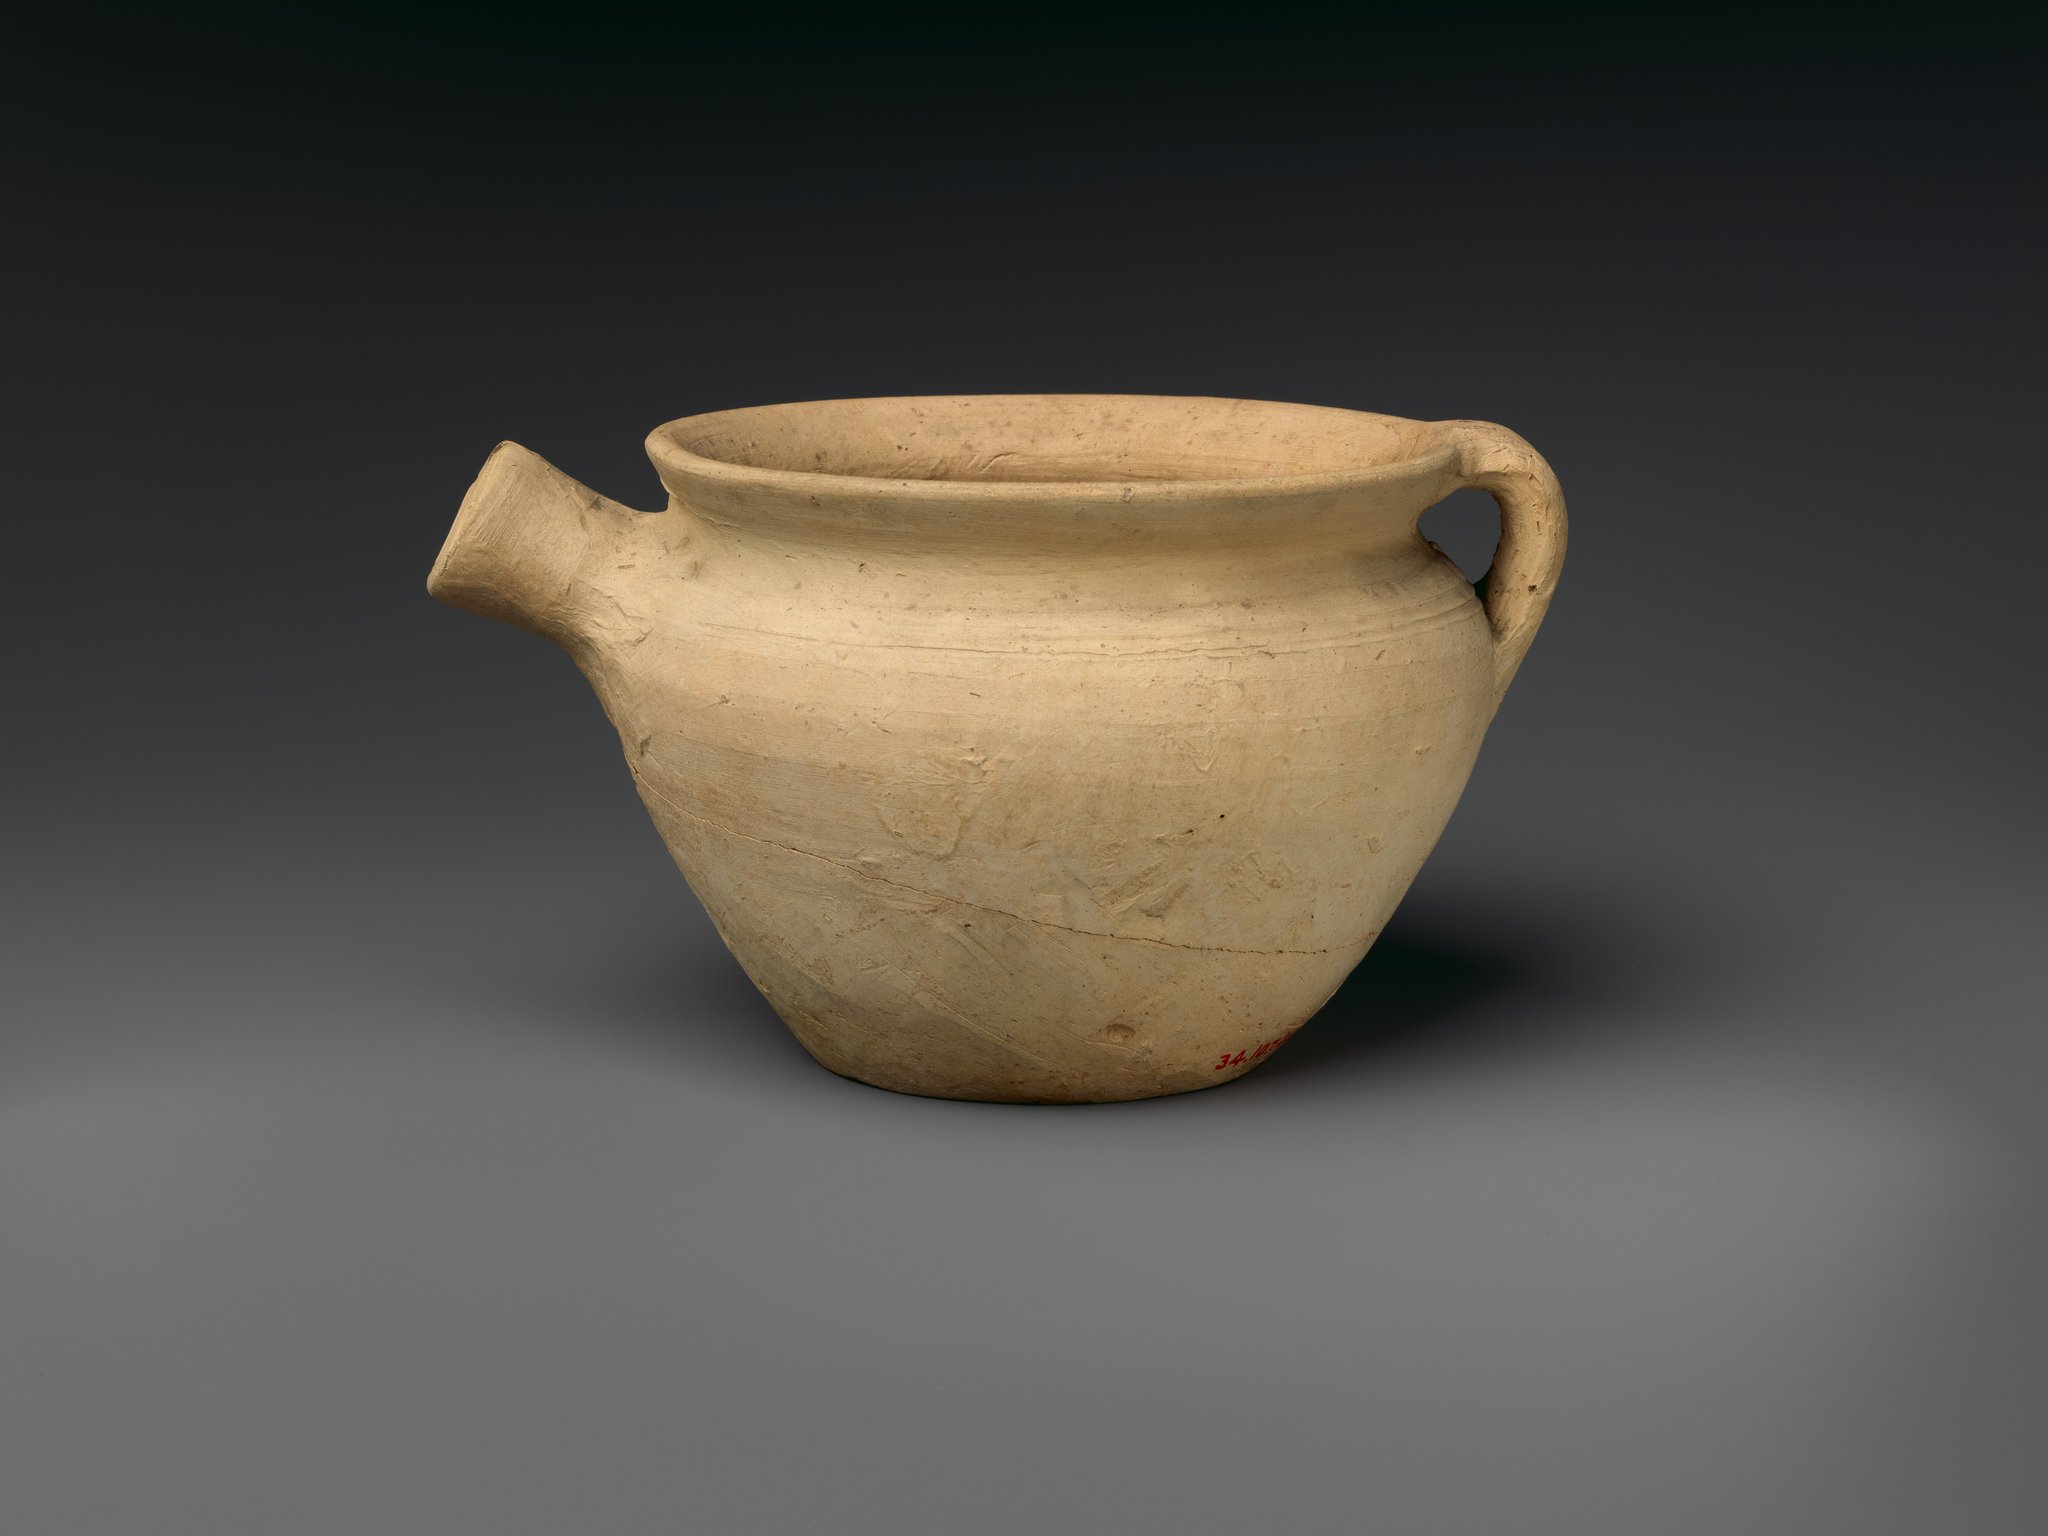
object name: pot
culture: sasanian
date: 201-700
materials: ceramic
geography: iran